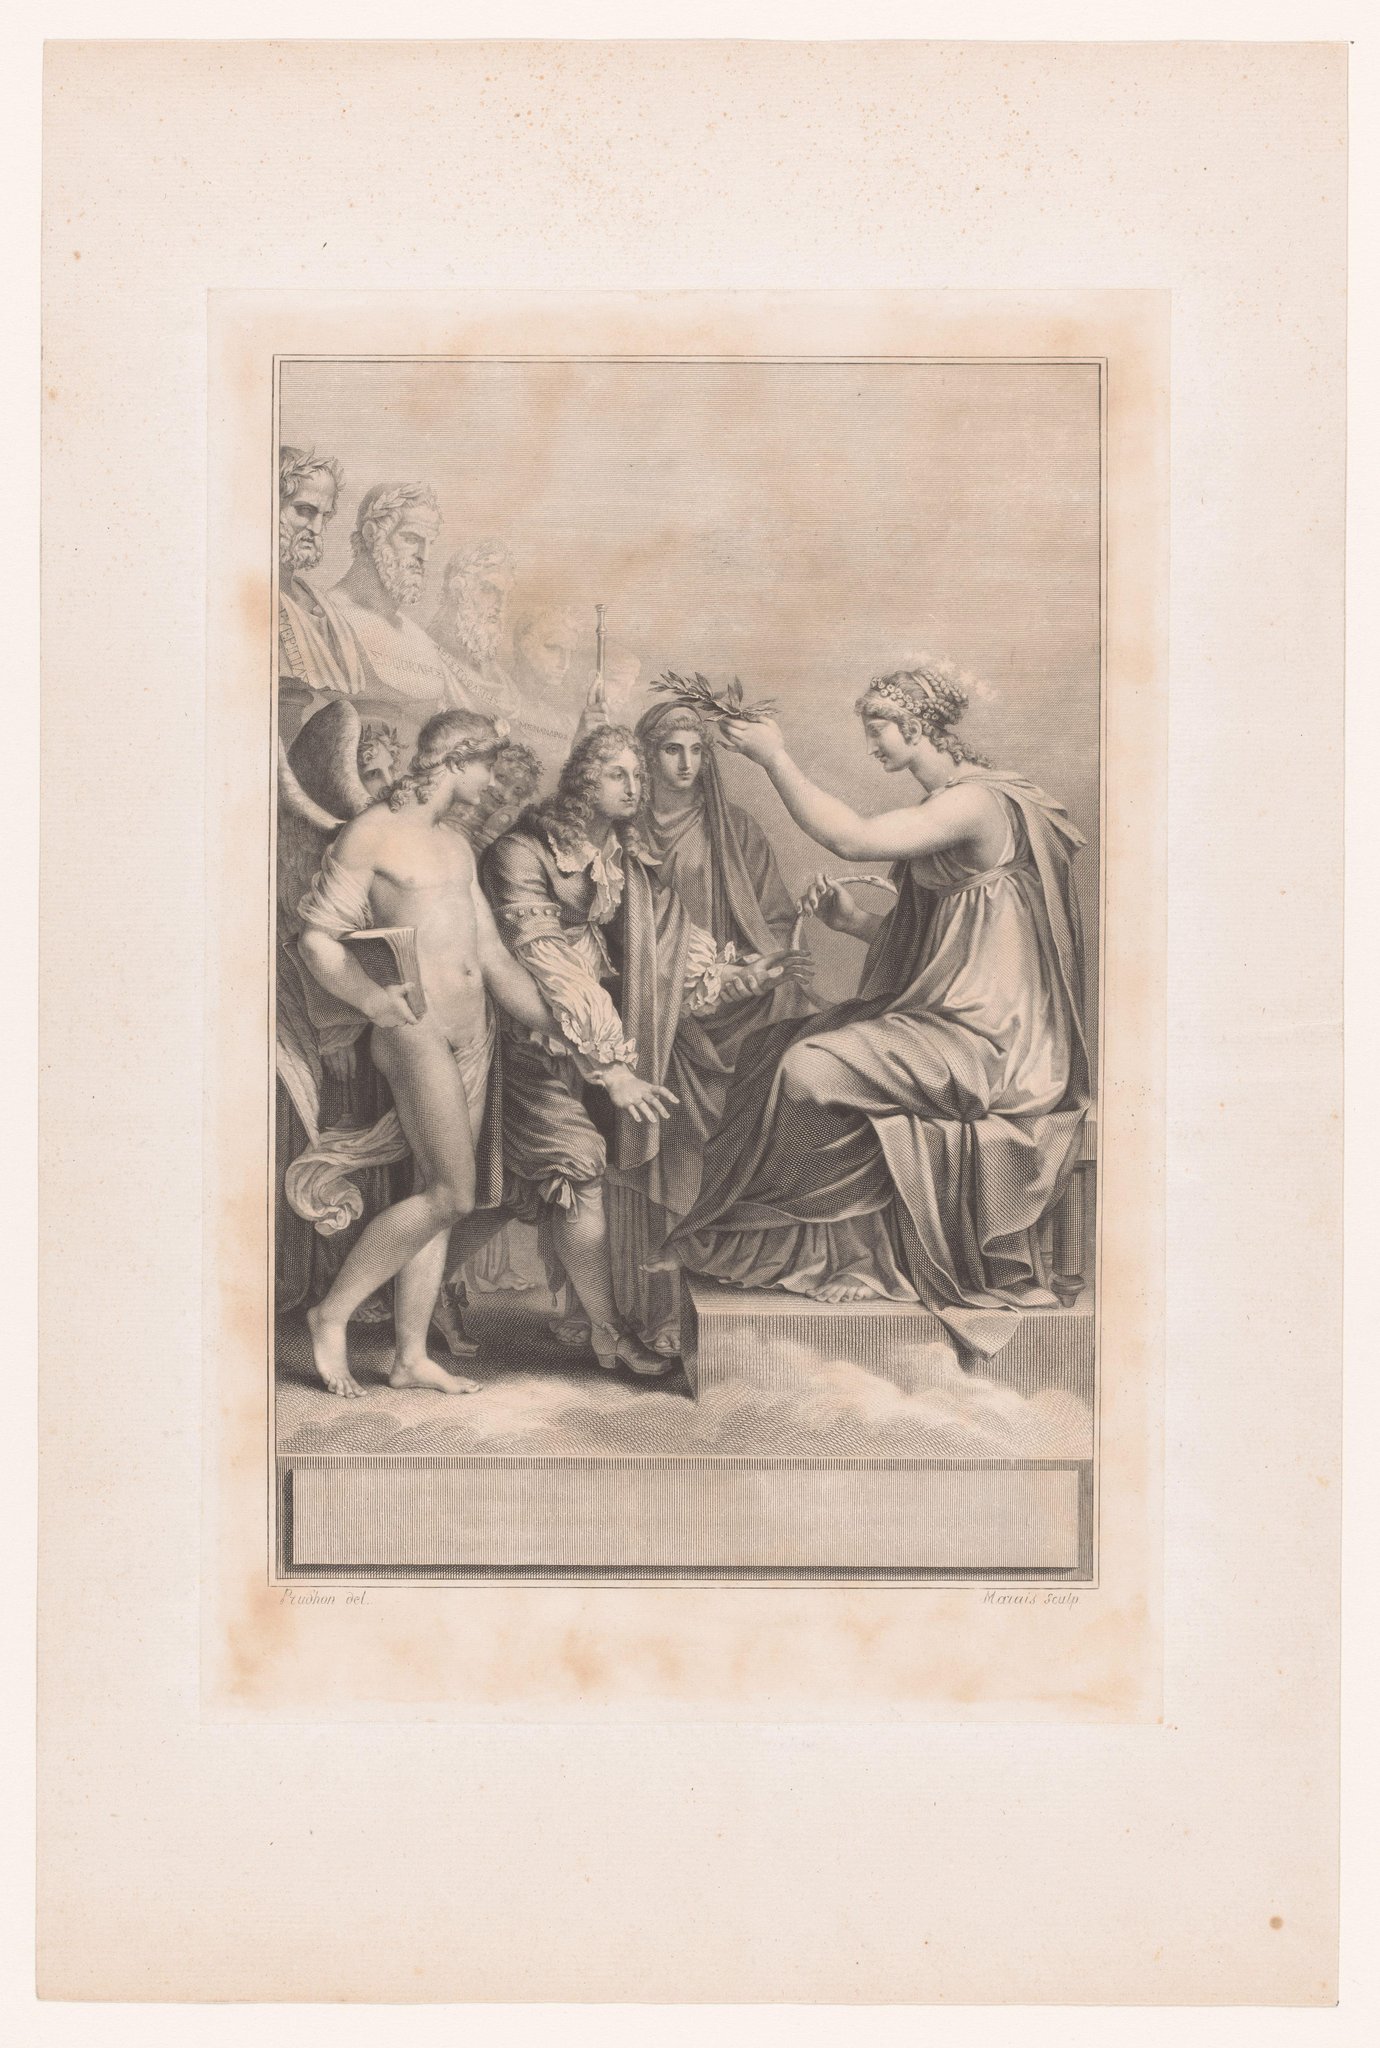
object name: print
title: Apotheose van Jean Racine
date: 1801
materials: paper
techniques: engraving, etching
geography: paris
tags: france, paris, jean racine, historical persons, melpomene (one of the muses); 'melpomene' (ripa), immortality, imperishableness; 'immortalità' (ripa), 'genio' (ripa)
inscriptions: collector's mark: Lugt 2228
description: Prent uit: Racine, Jean. Oeuvres de Jean Racine. Parijs: Pierre I Didot, 1801, dl. 1.